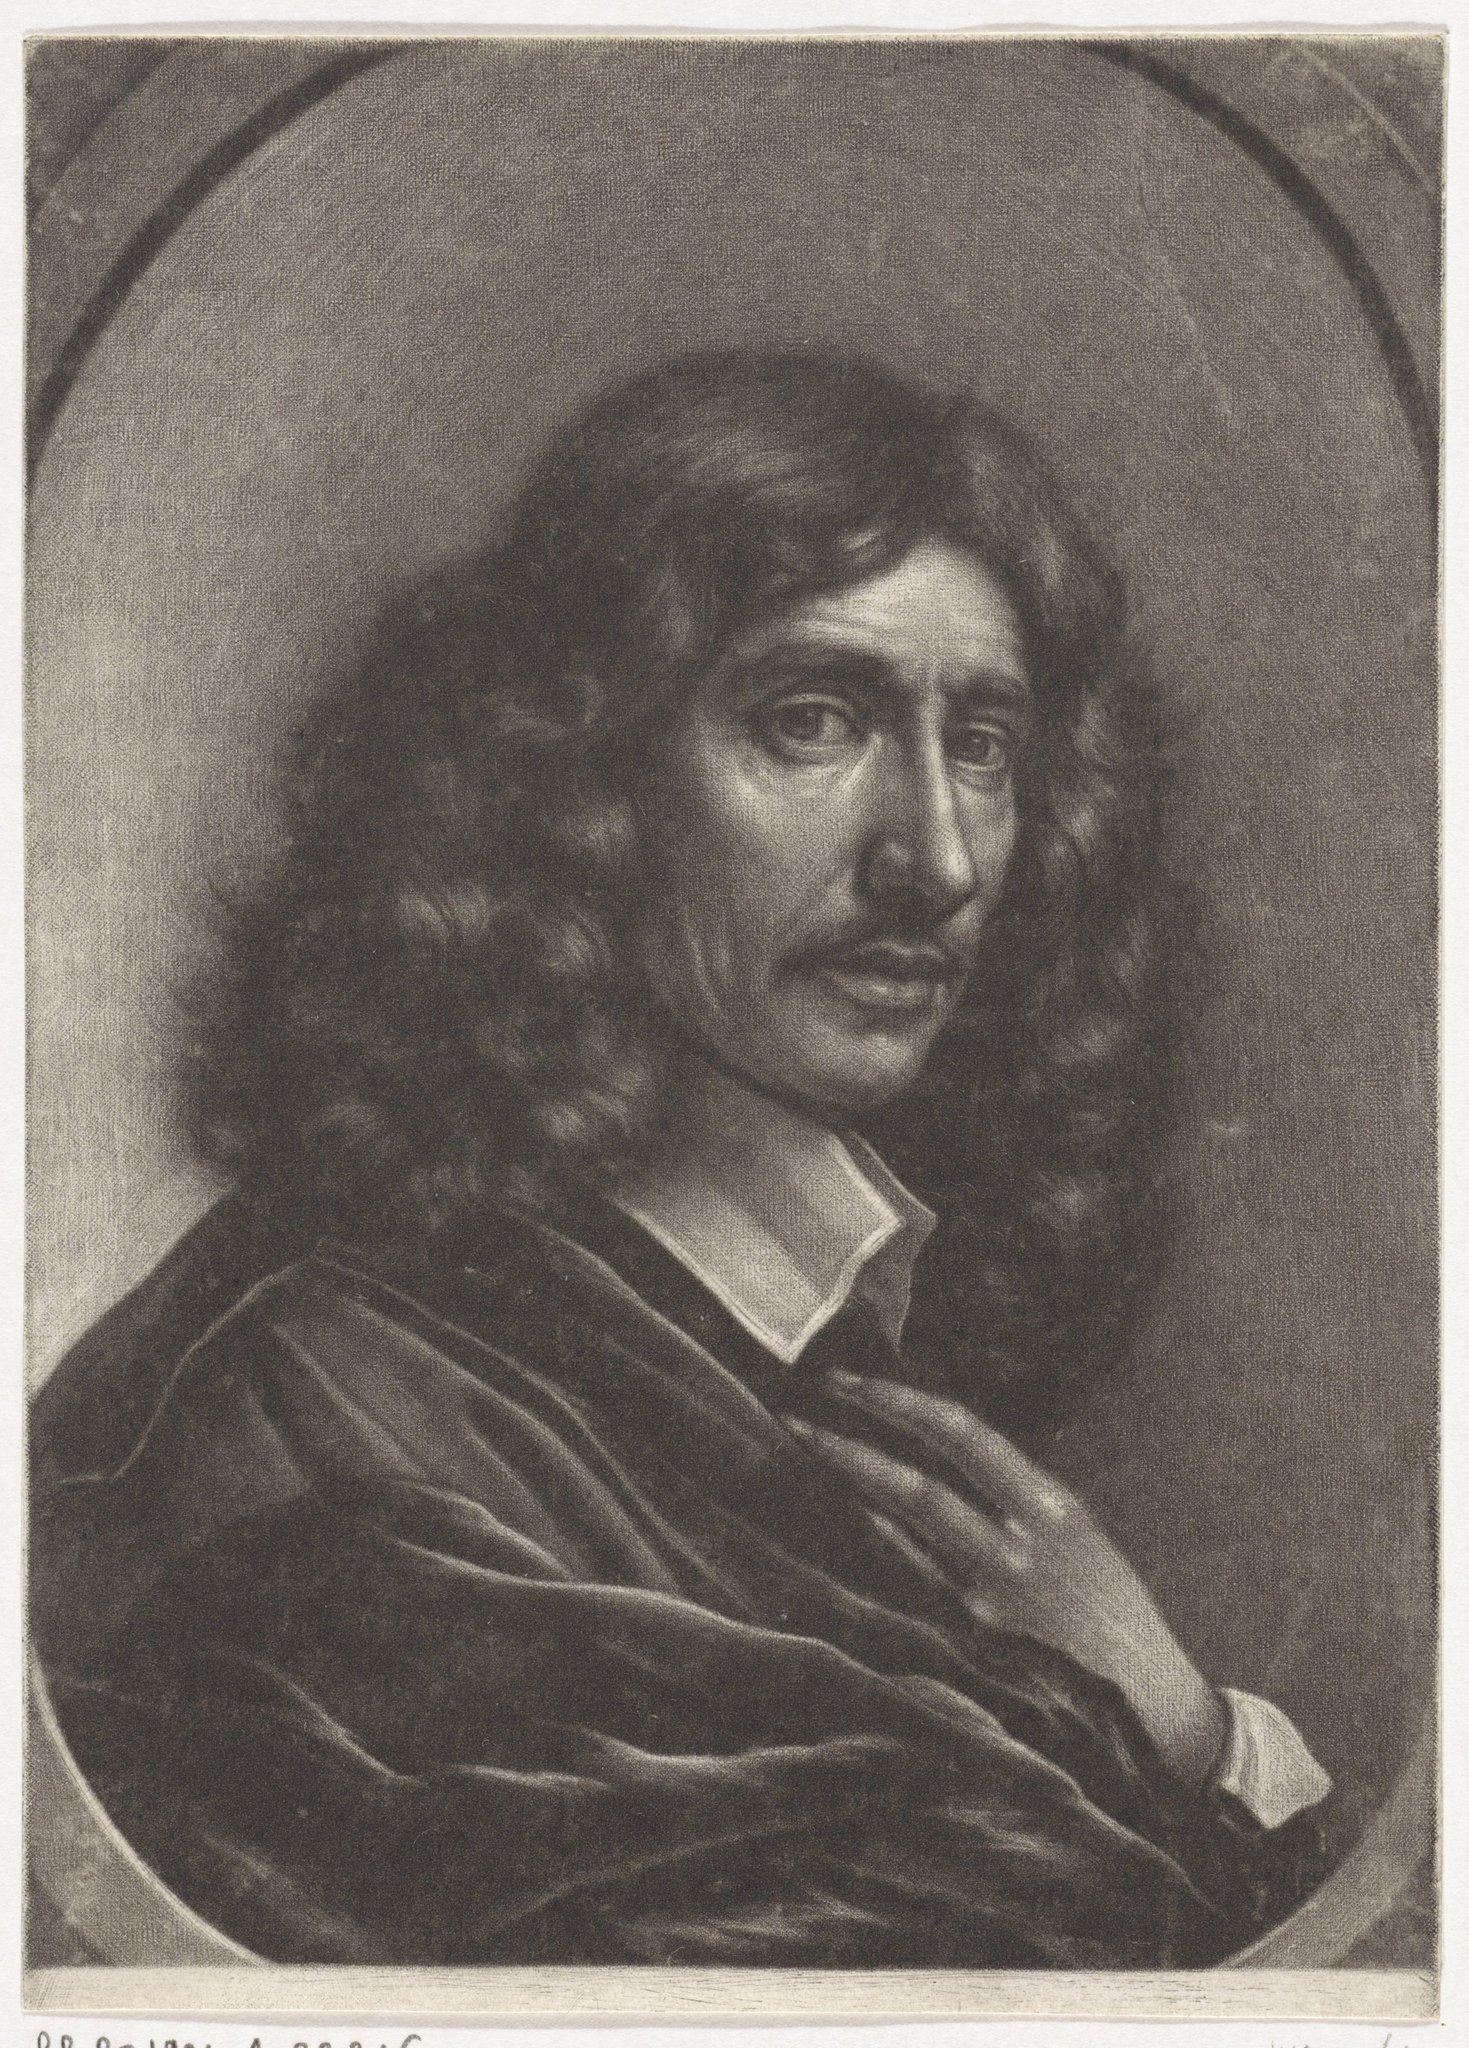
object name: print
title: Portret van een man, naar rechts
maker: wallerant vaillant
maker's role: draughtsman, painter, print maker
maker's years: 1623-1677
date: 1658-1677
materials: paper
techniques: mezzotint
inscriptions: collector's mark: Lugt 2228